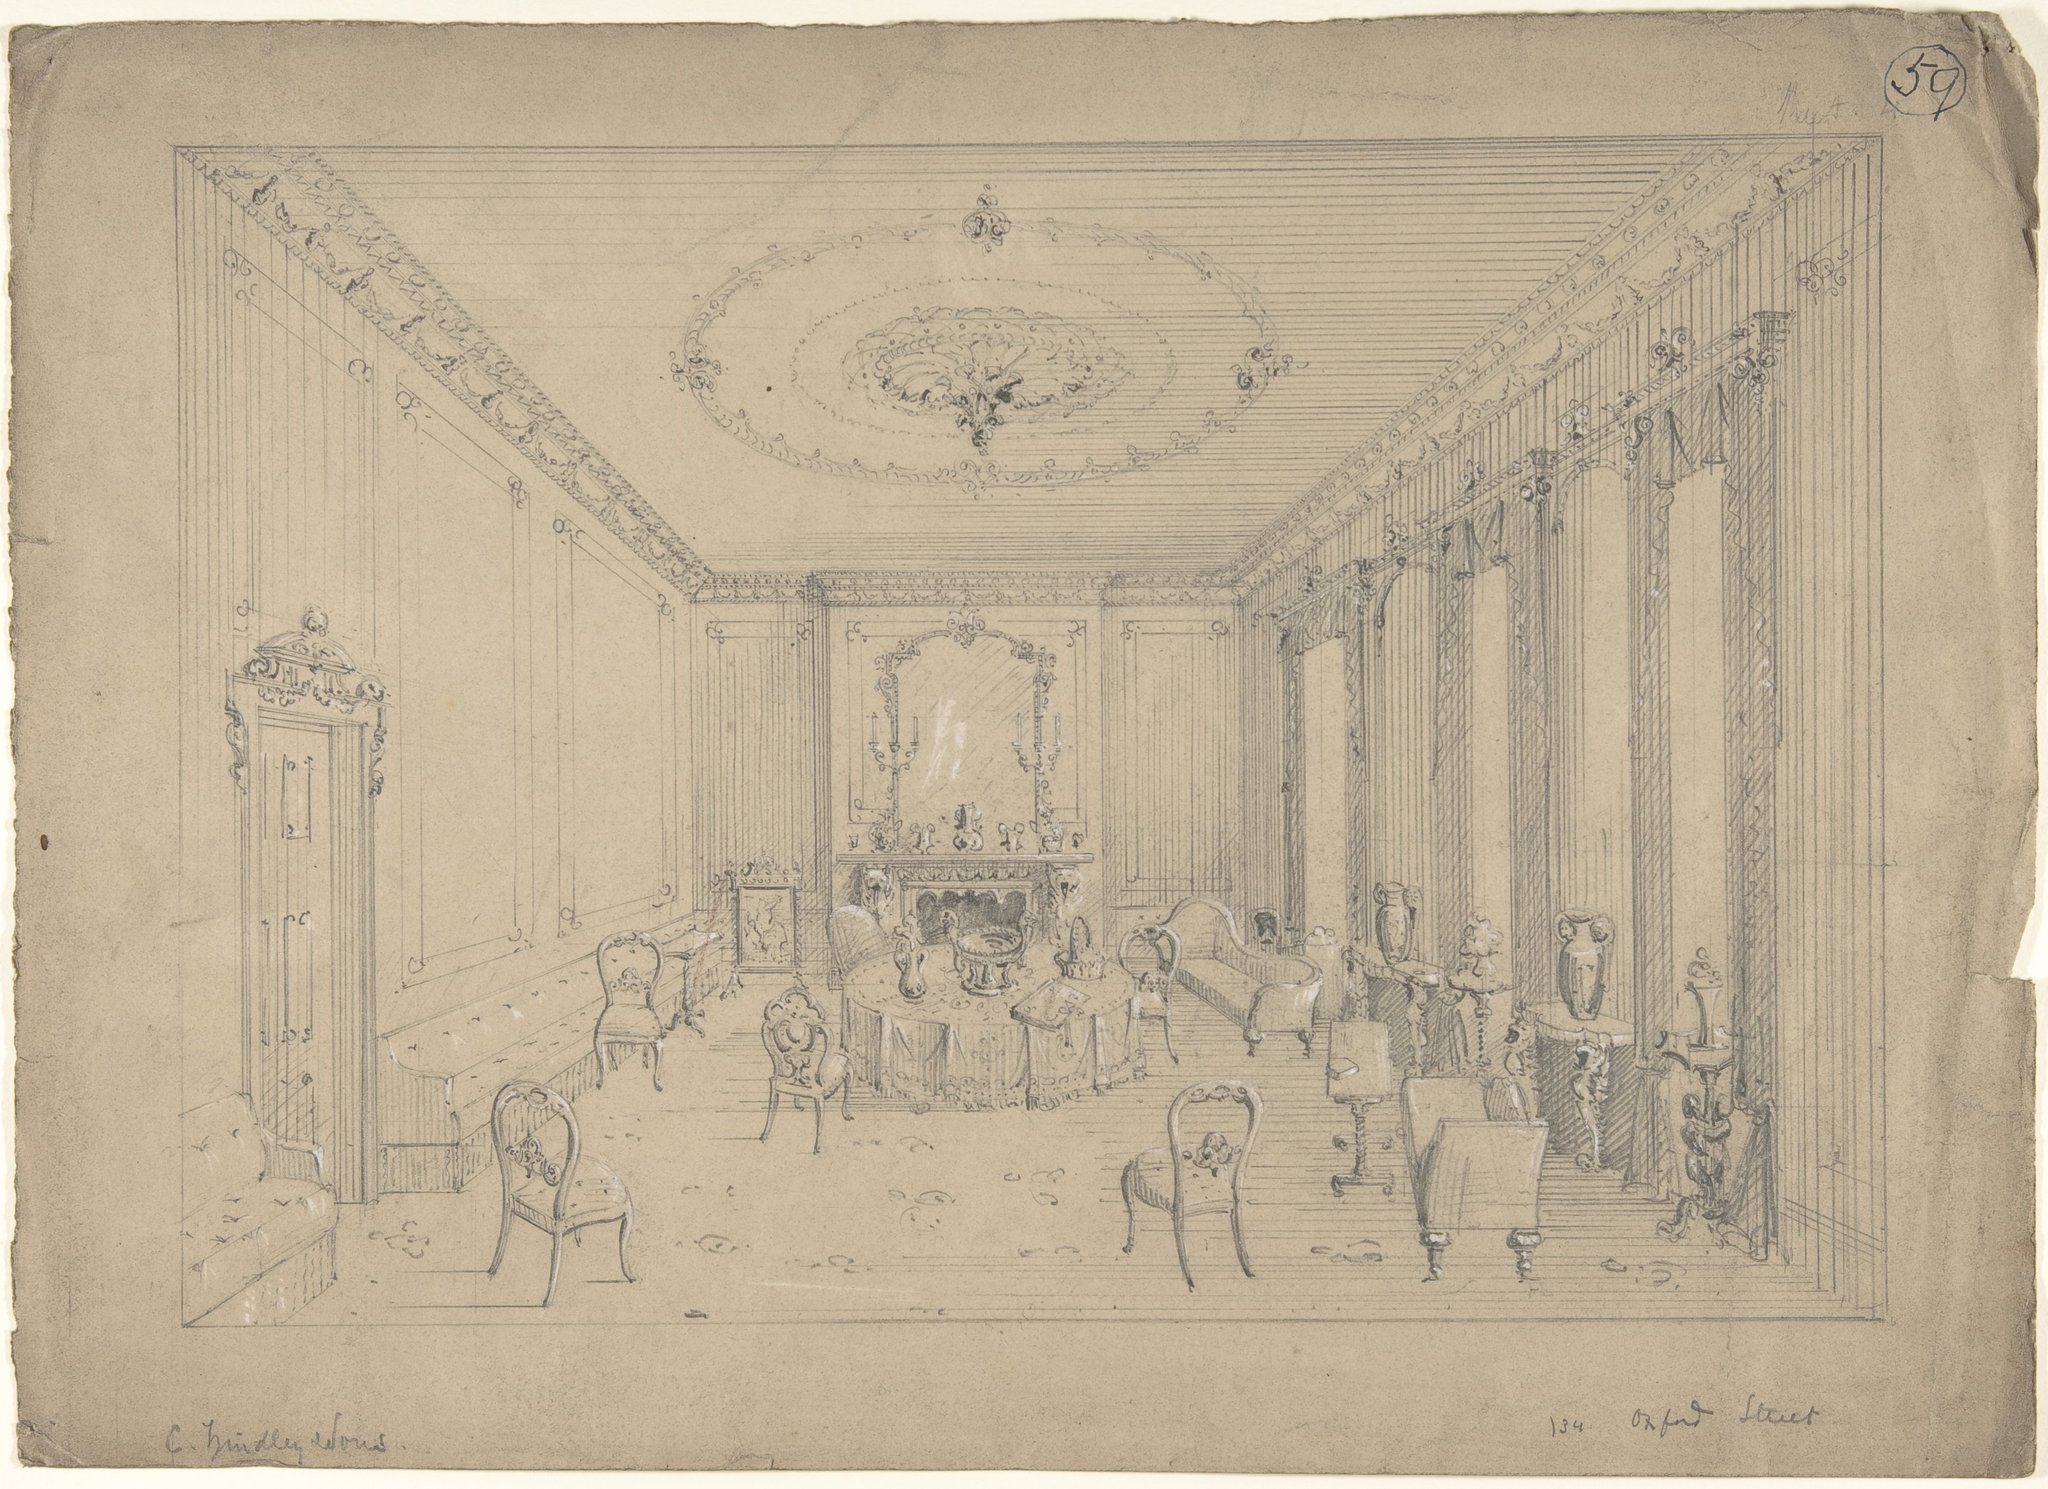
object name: drawing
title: Design for a Sitting Room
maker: charles hindley and sons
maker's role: artist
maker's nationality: british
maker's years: 1841-1917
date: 1841-1884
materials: gouache, graphite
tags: interiors,living rooms,chairs,tables